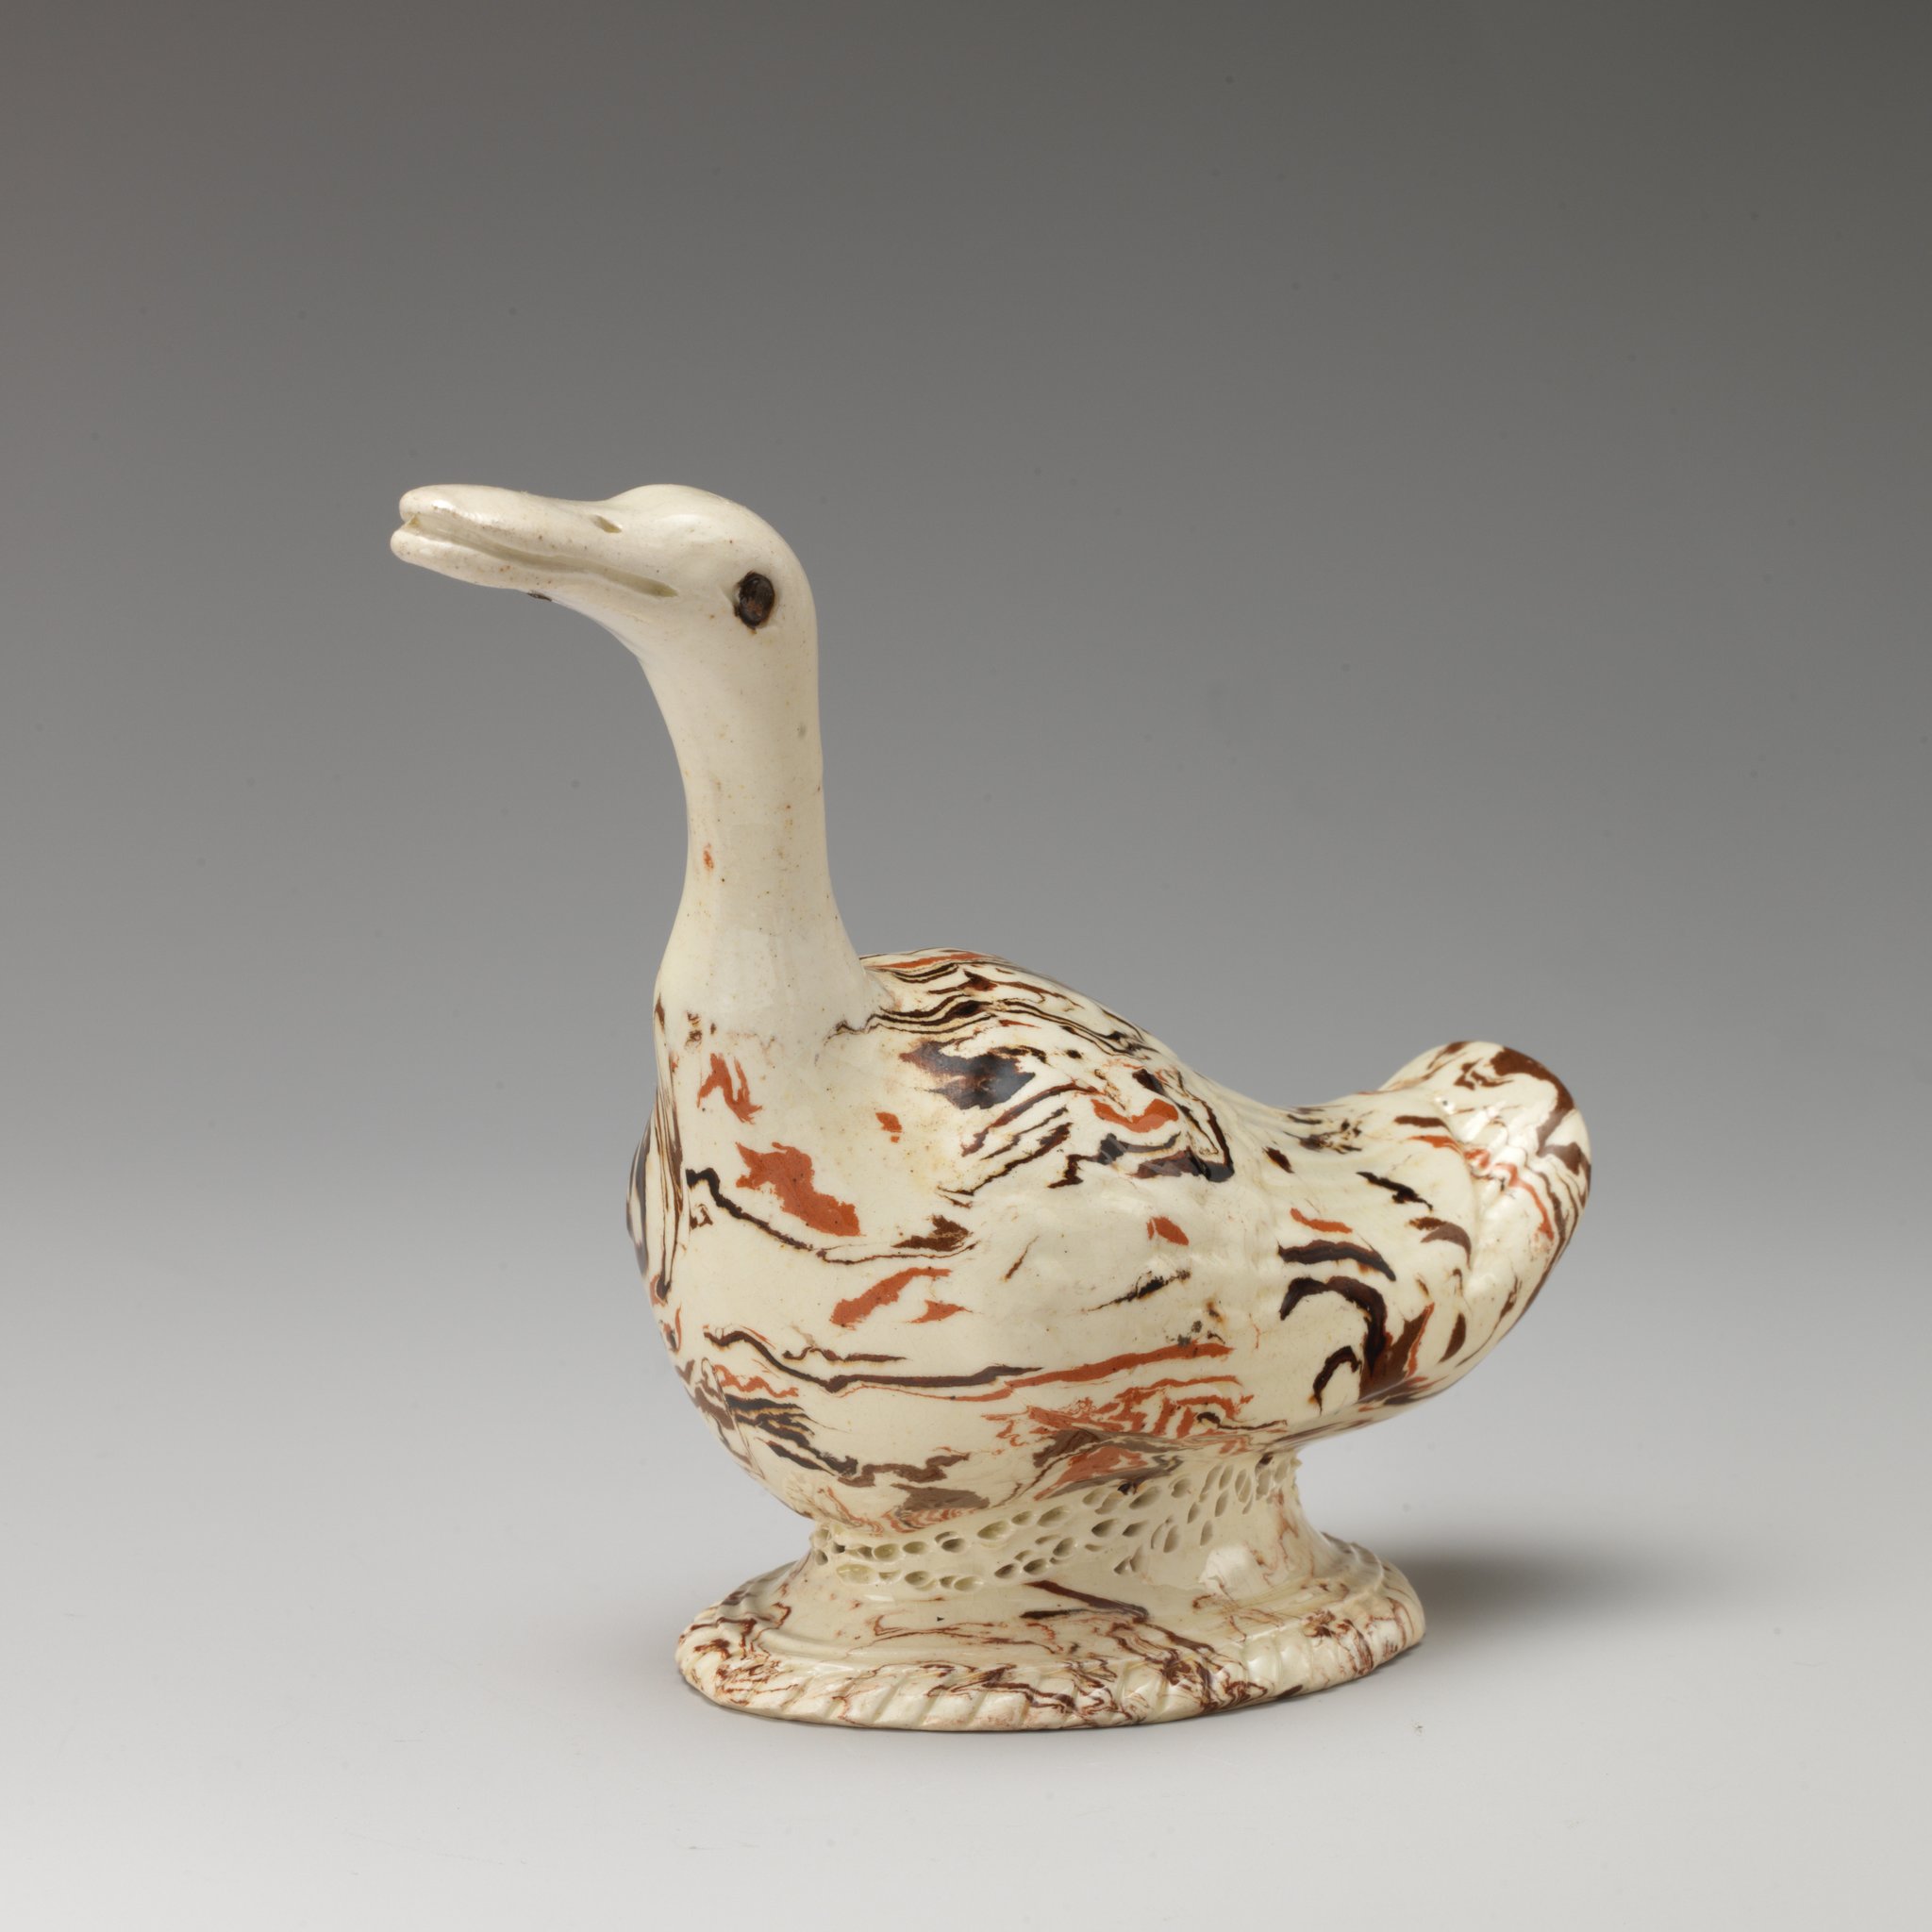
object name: figure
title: Duck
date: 1750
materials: earthenware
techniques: glazing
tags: ducks